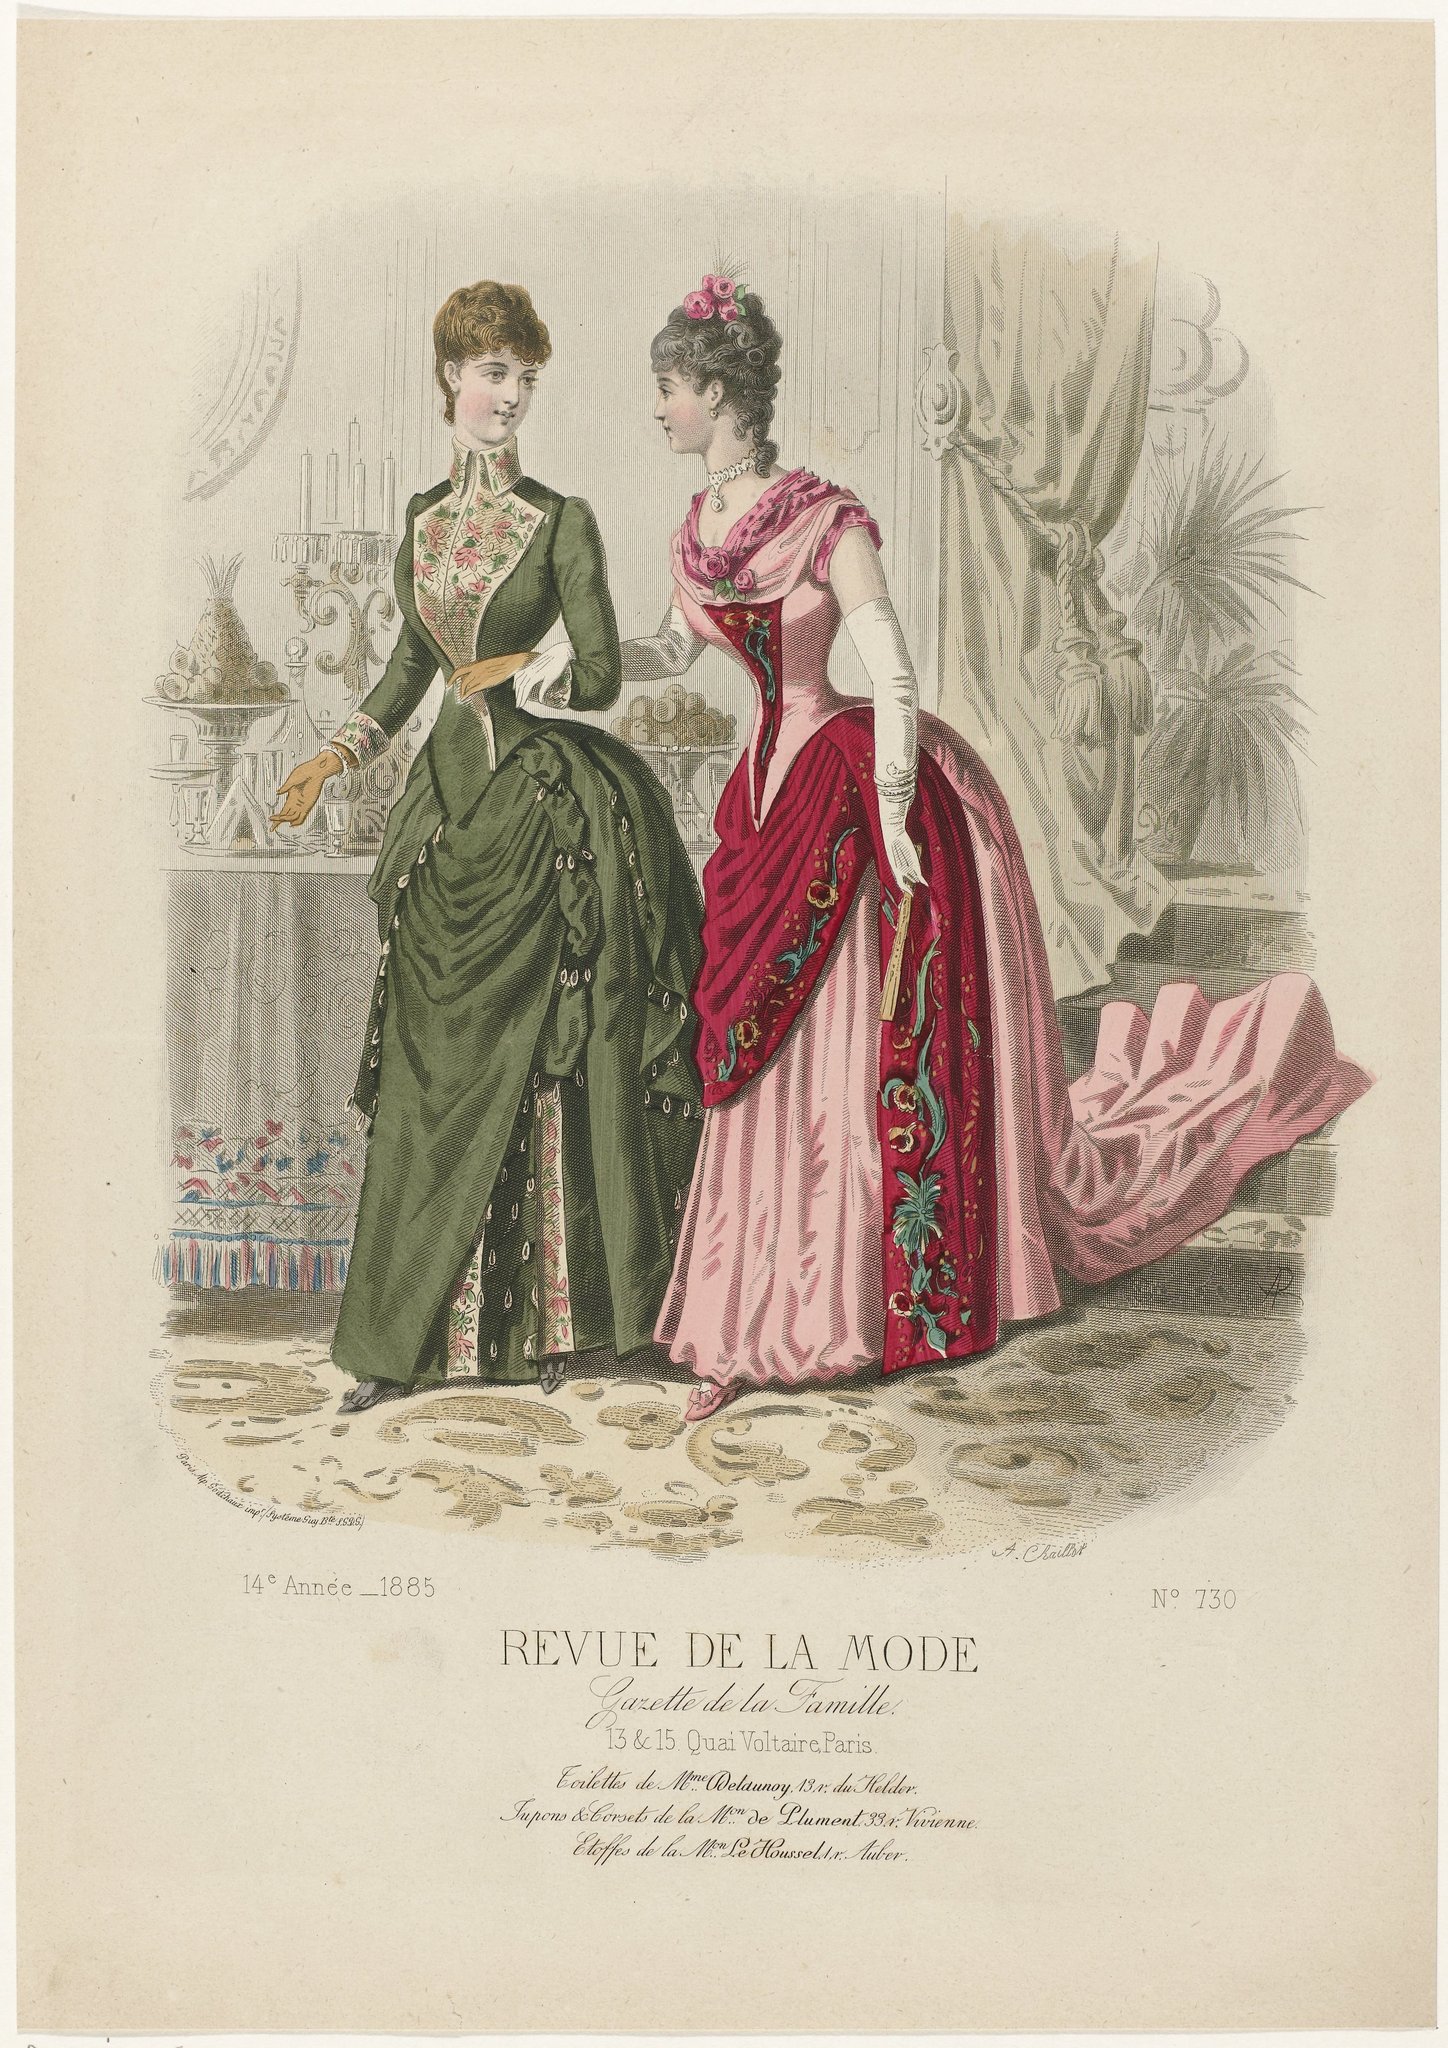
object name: fashion print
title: Revue de la Mode, Gazette de la Famille, dimanche 27 décembre 1885, 14e Année, No. 730: Toilettes de Mme Delannoy (...)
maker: a. chaillot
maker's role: print maker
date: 1885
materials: paper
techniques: engraving, hand coloring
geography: paris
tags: corsage (+ women's clothes), flowers, gloves, mittens (long gloves) (+ women's clothes), arm in arm (friends), fashion plates, skirt (+ women's clothes), dress, gown (+ women's clothes), bracelet, wristlet (+ women's clothes), necklace (+ women's clothes), laid table: table-ware, table-decoration, etc.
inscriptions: title: ‘REVUE DE LA MODE / Gazette de la Famille’, address: ‘13 & 15, Quai Voltaire Paris’, caption: ‘Toilettes de M.me Delannoy, 13, r. du Helder. Jupons & Corsets de la M.on de Plument, 33, r. Vivienne. Etoffes de la M.on Le Houssel 1 r. Auber.’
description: Twee vrouwen in japonnen van Delannoy. Ze staan gearmd in een interieur, op de achtergrond een gedekte tafel. Links: japon van satijn gebrocheerd met fluweel en crèmekleurige wol. Rechts: japon van beige fijne wol en gebrocheerde zijde versierd met kralen. Accessoires: collier, bloemcorsage, lange handschoenen, armband in de vorm van een slang, waaier, schoenen met hakken en strikken. Met enkele regels reclametekst voor verschillende producten. Prent uit het modetijdschrift Revue de la Mode (1872-1913). Uitgebreide beschrijving van de kleding op pagina 412 en 413 "PLANCHE COLORIÉE".